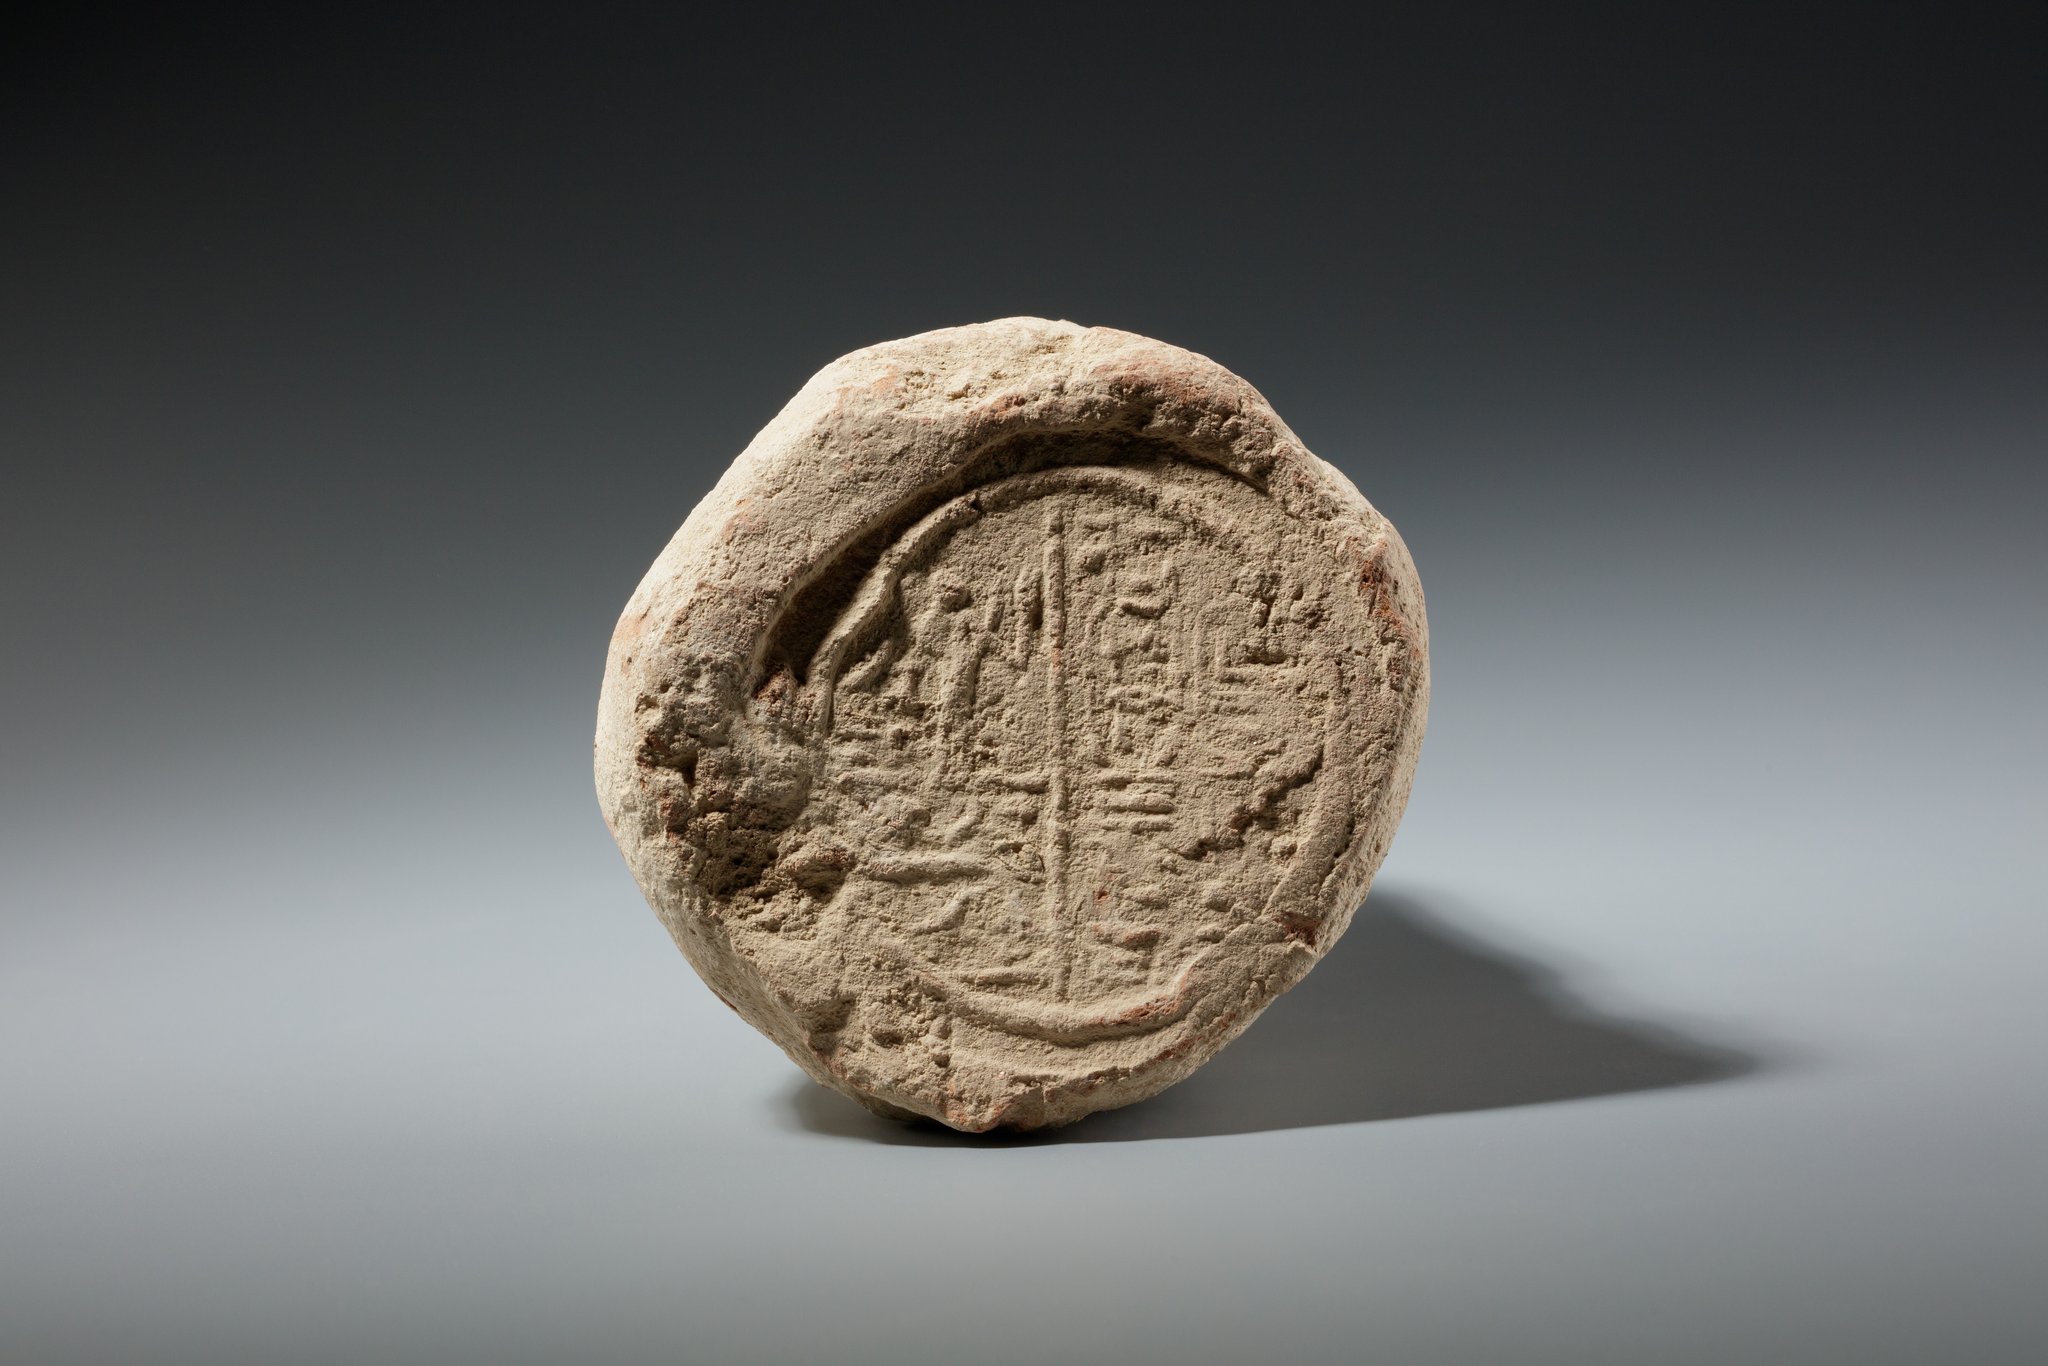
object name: cone, davy 584, amenirdis, king's daughter, kashta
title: Funerary Cone Naming a Butler of the God's Hand Amenirdis Daughter of Kashta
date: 740-700 BCE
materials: pottery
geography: egypt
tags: hieroglyphs